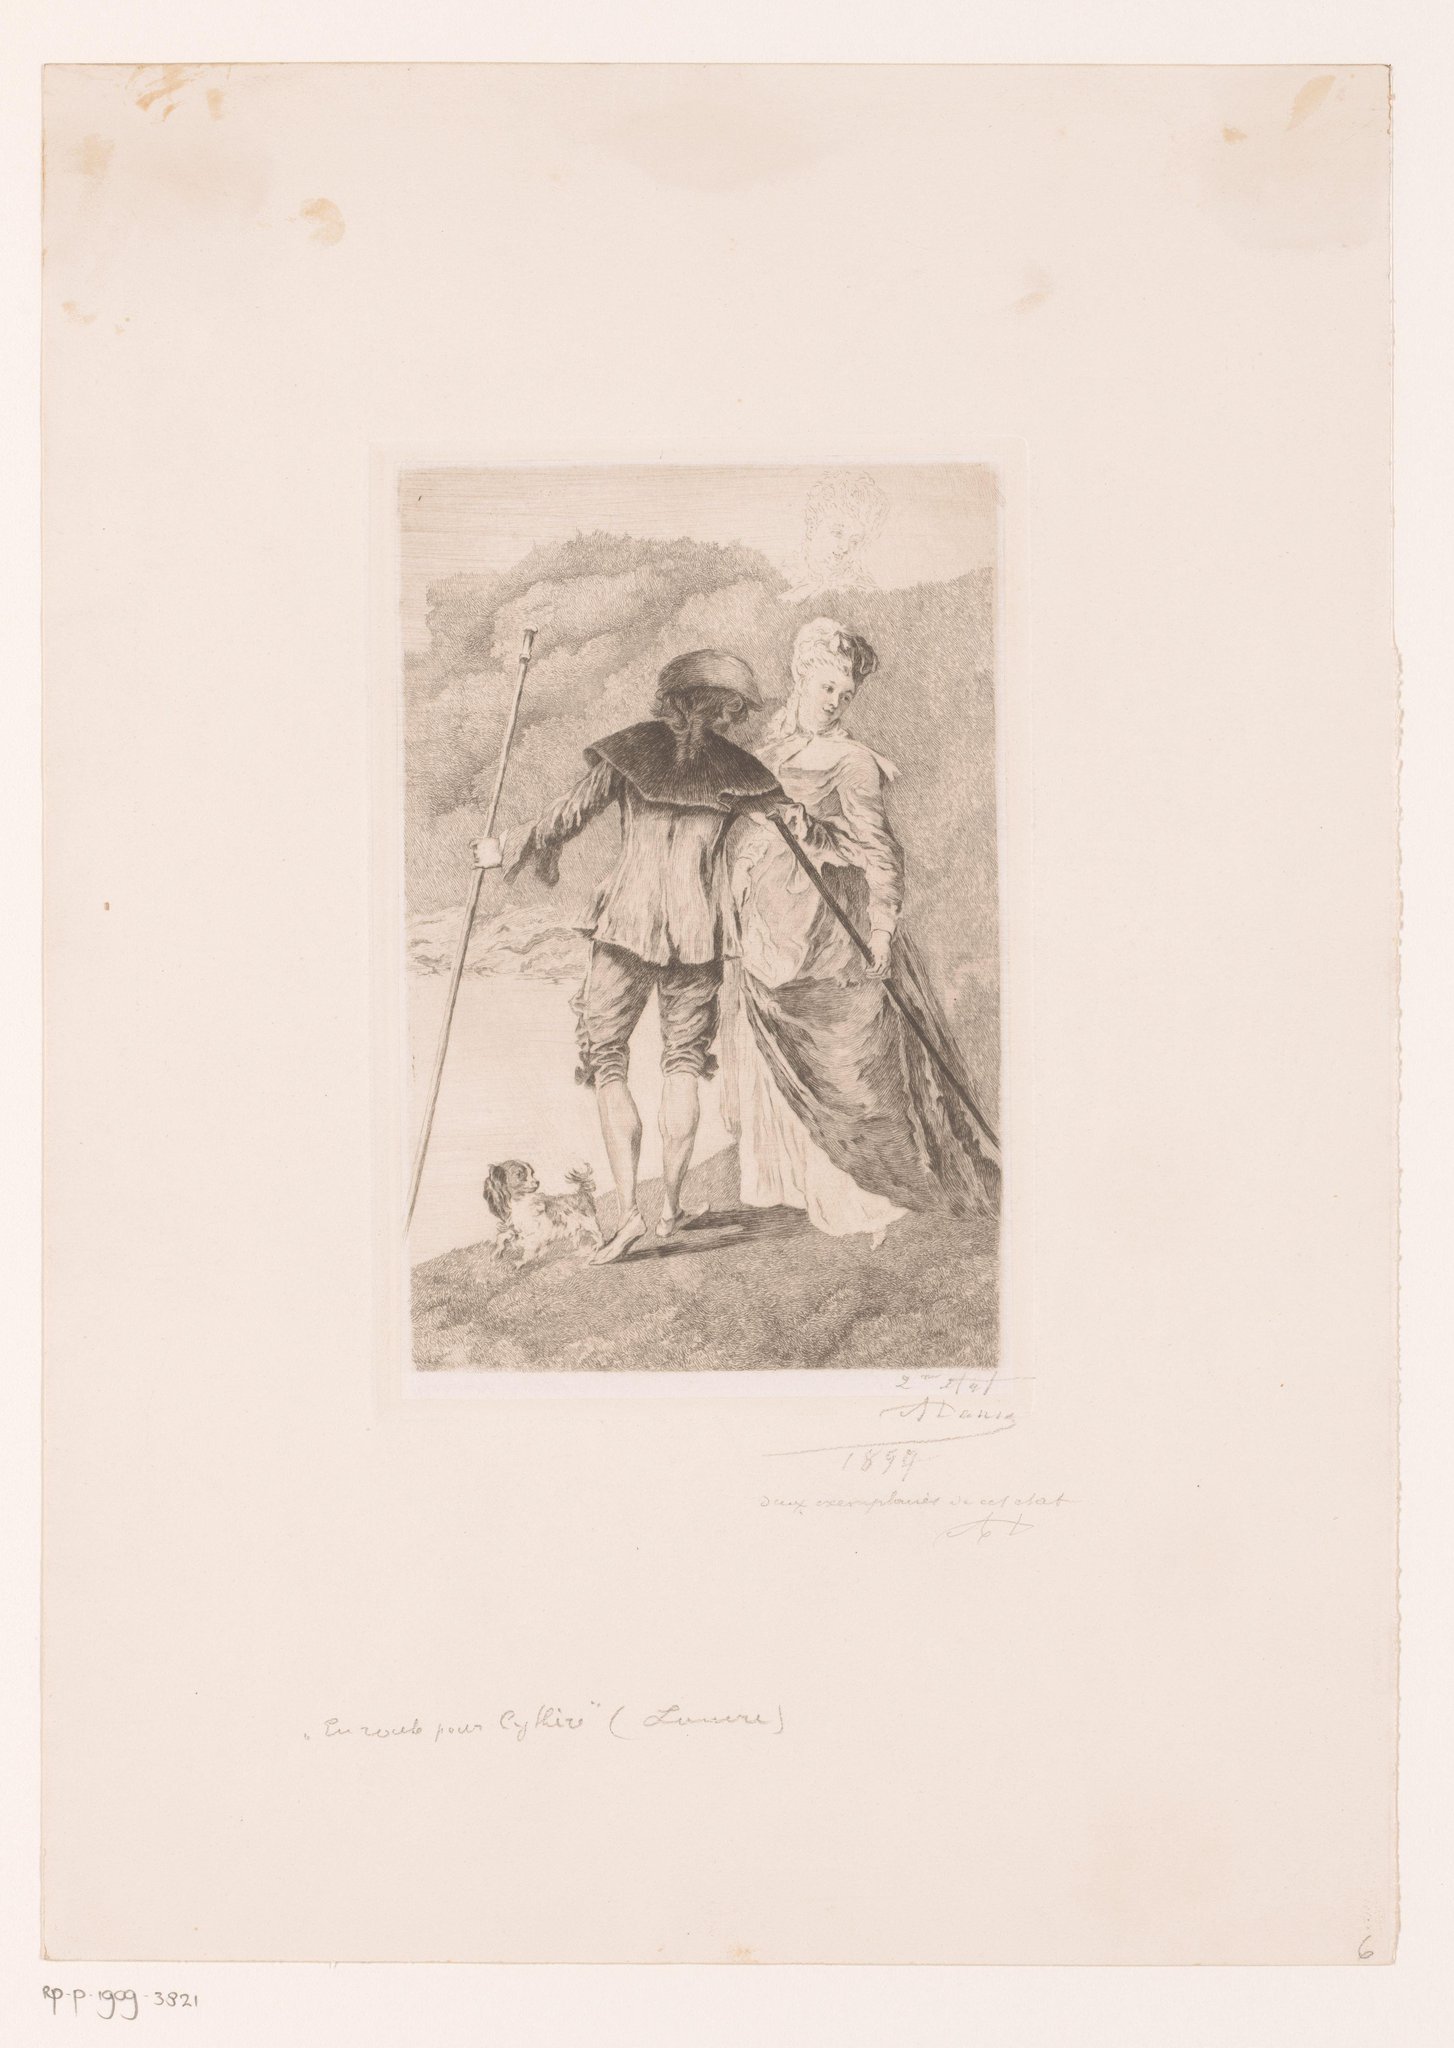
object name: print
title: Romantisch koppel edellieden met een hond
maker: auguste danse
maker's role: print maker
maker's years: 1829-1929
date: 1897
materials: paper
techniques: drypoint, etching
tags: (lovers) embracing each other, 'symplegma'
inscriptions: annotation: ‘2me état; deux exemplaires de cet etat’, collector's mark: Lugt 2228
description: Dit detail is het centrale paar in het schilderij L'Embarquement pour Cythère.